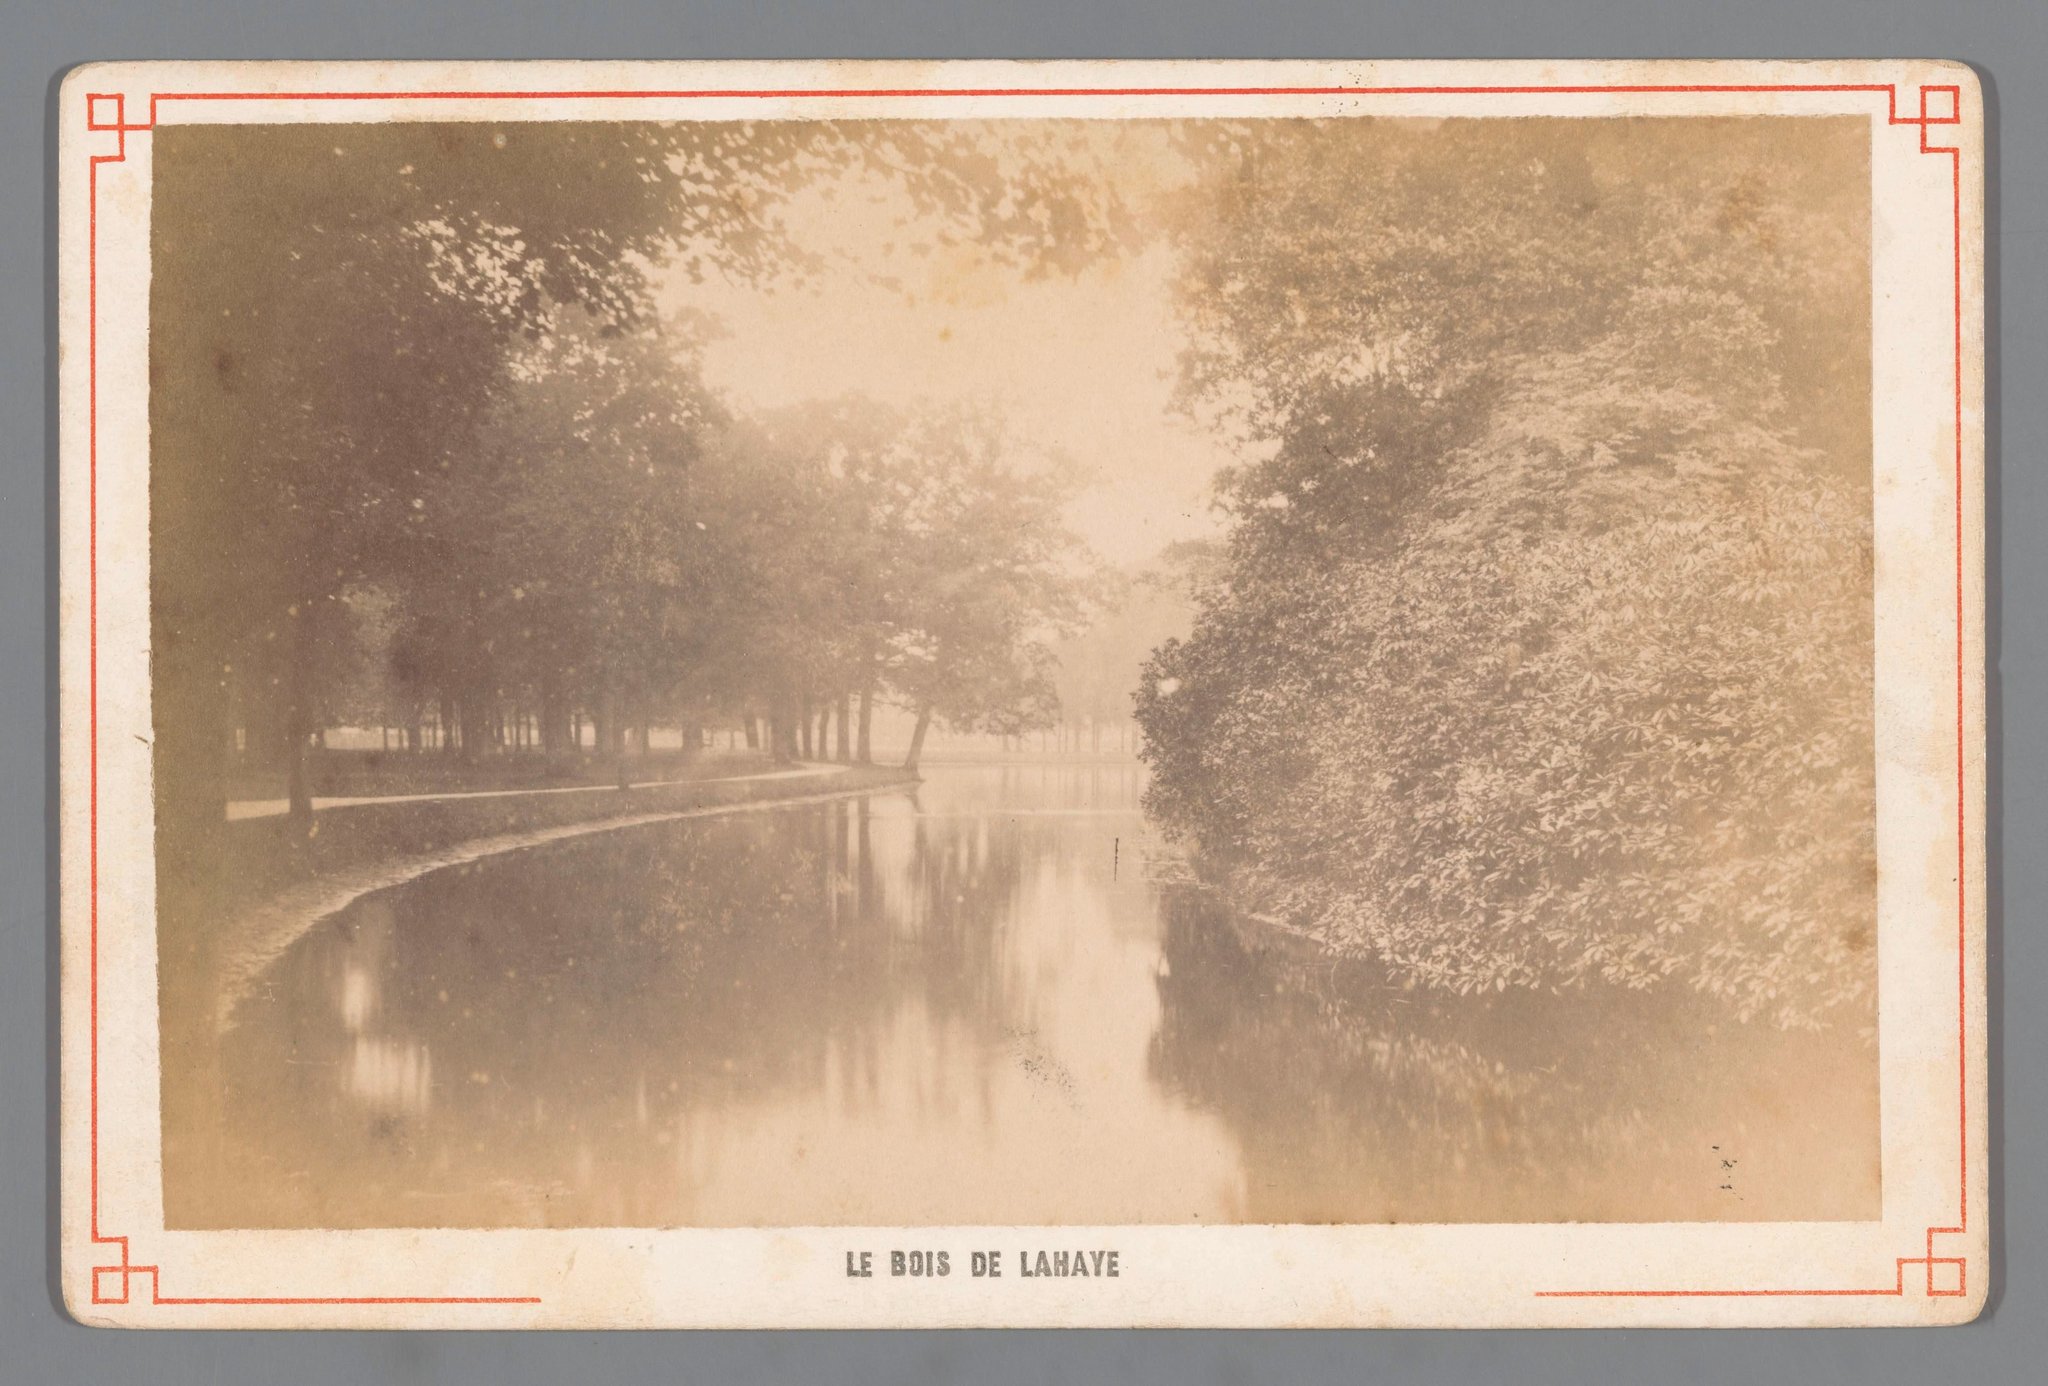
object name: photograph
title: Le bois de Lahaye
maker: Anonymous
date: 1880-1900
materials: cardboard, photographic support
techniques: albumen print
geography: haagse bos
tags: pool, puddle, public gardens, park